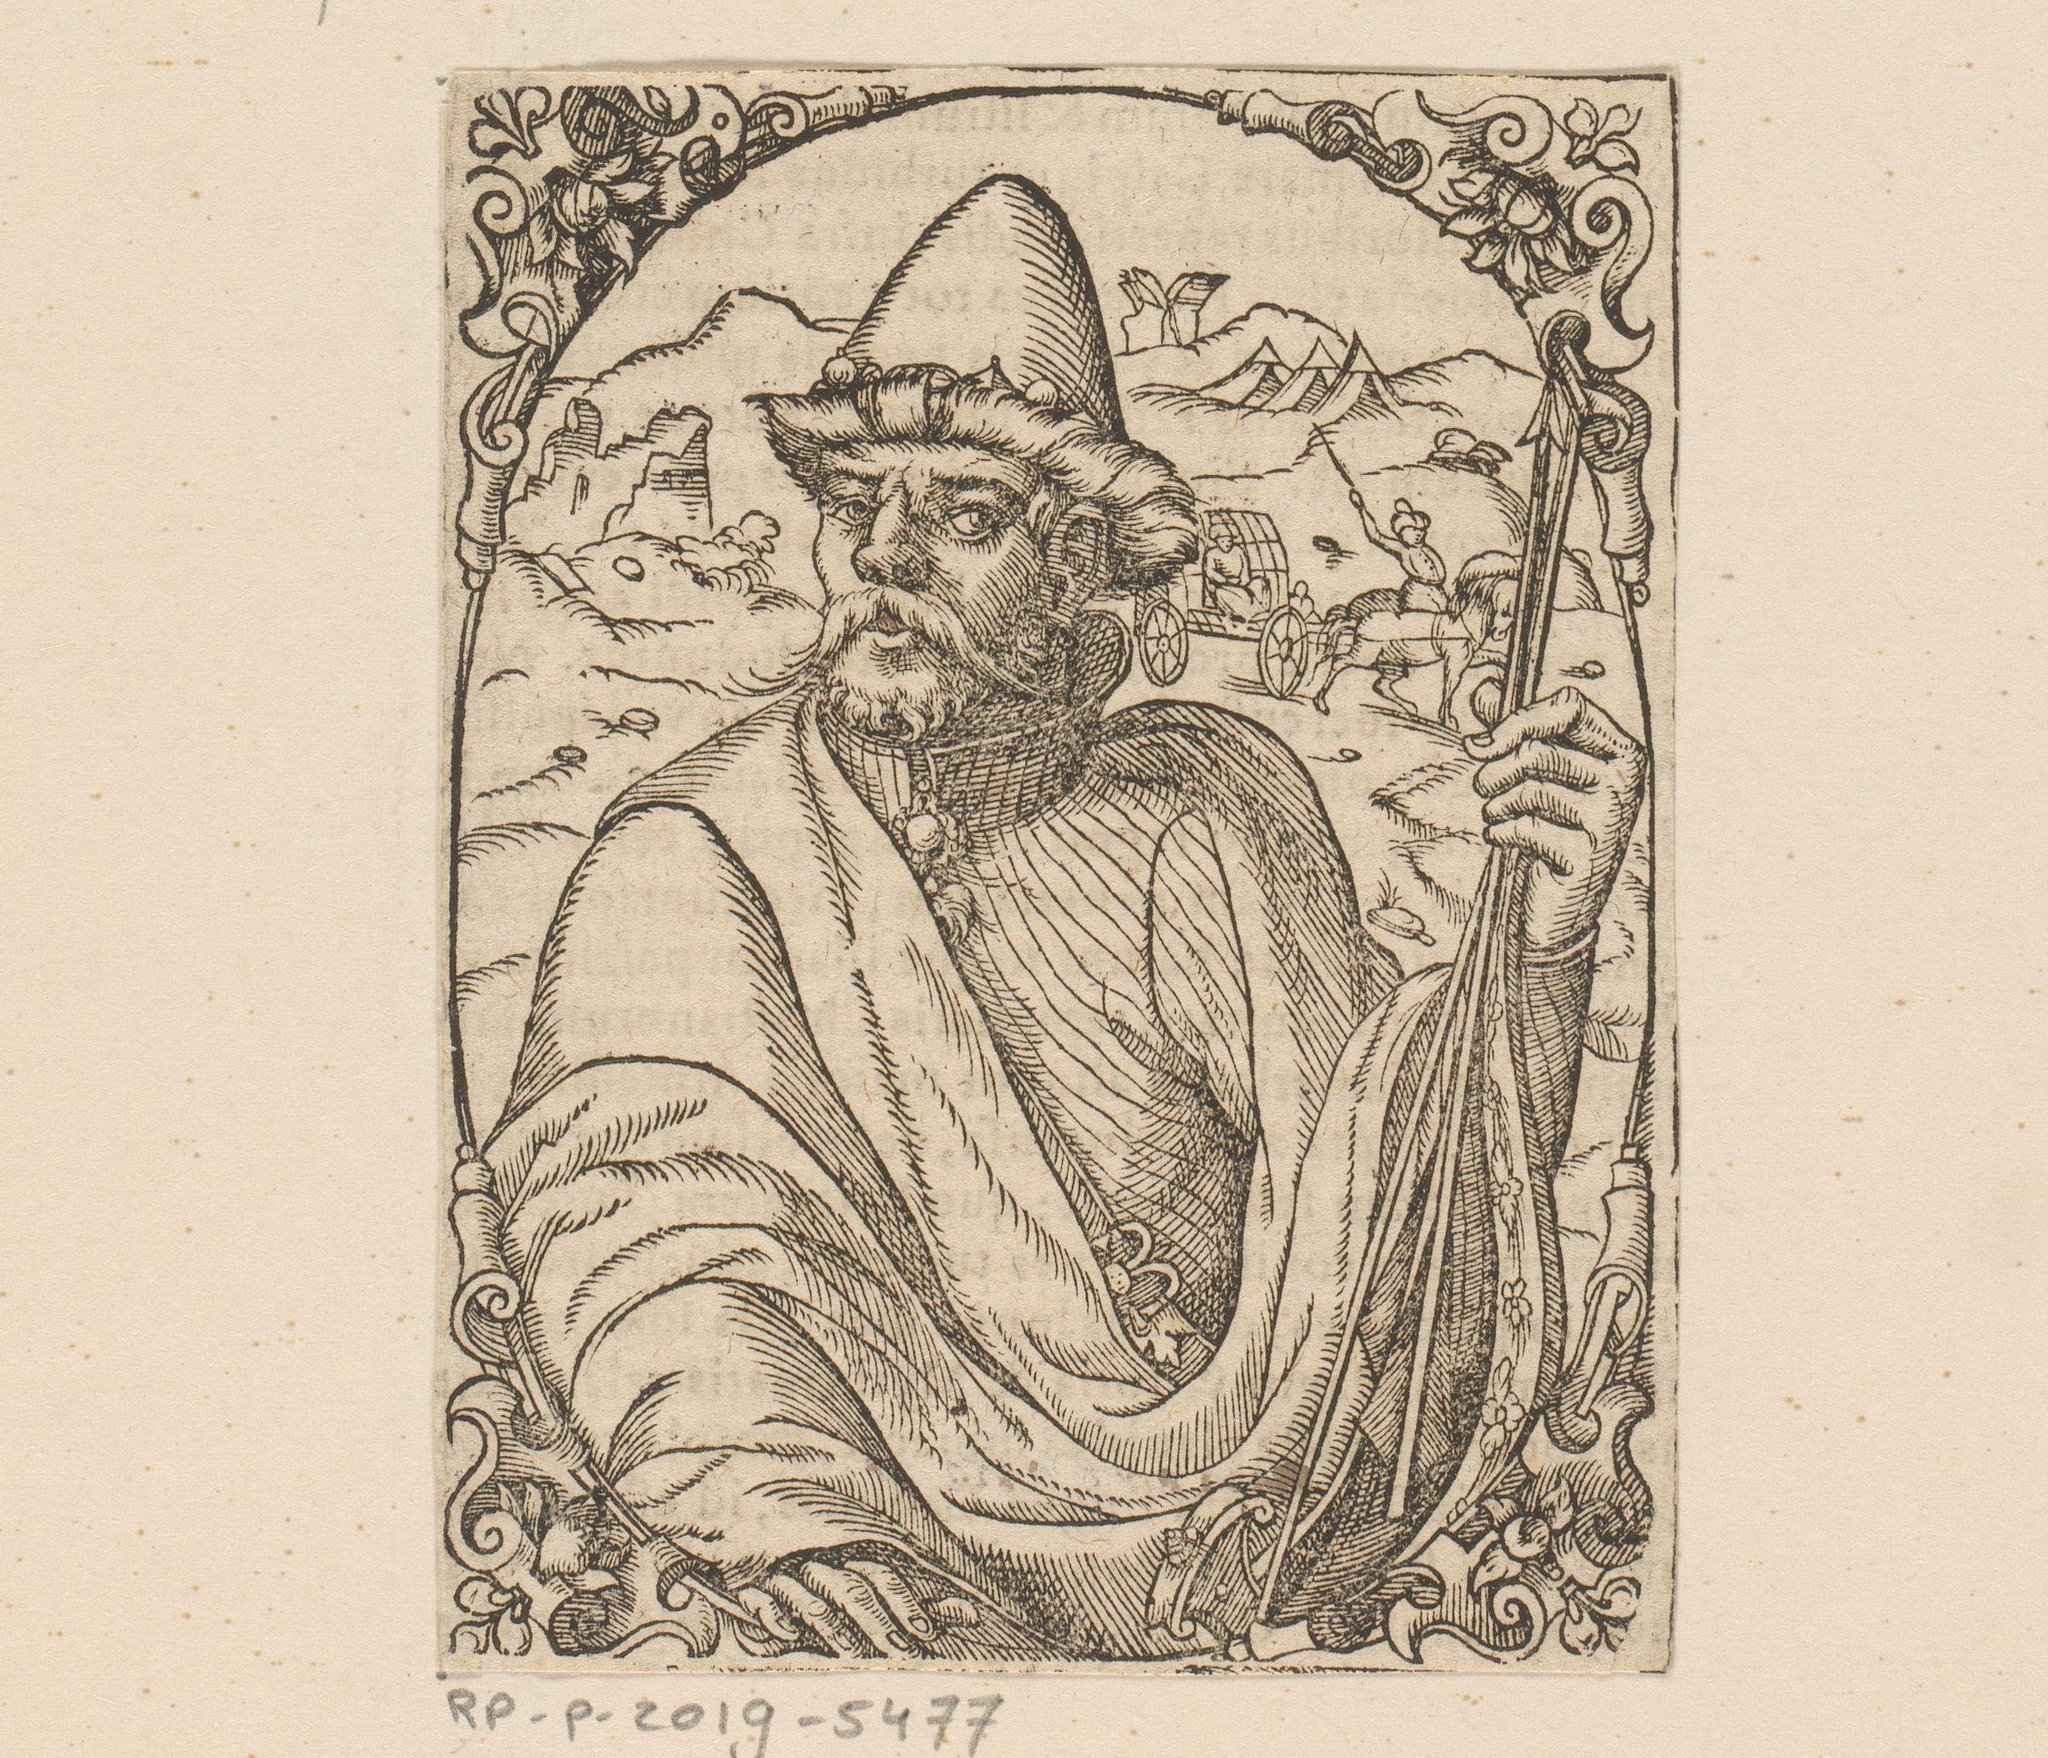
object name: print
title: Portret van Timoer Lenk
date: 1596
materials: paper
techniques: letterpress printing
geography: basel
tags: historical persons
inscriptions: inscription: ‘Tamerlane’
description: Prent uit: Giovio, Paolo. Elogia virorum bellica virtute illustrium, (...). Bazel: Peter Perna, 1596. Prent eerder verschenen in: Giovio, Paolo. Elogia virorum bellica virtute illustrium (...). Bazel: Peter Perna, 1575. Prent ook gebruikt in andere publicaties.